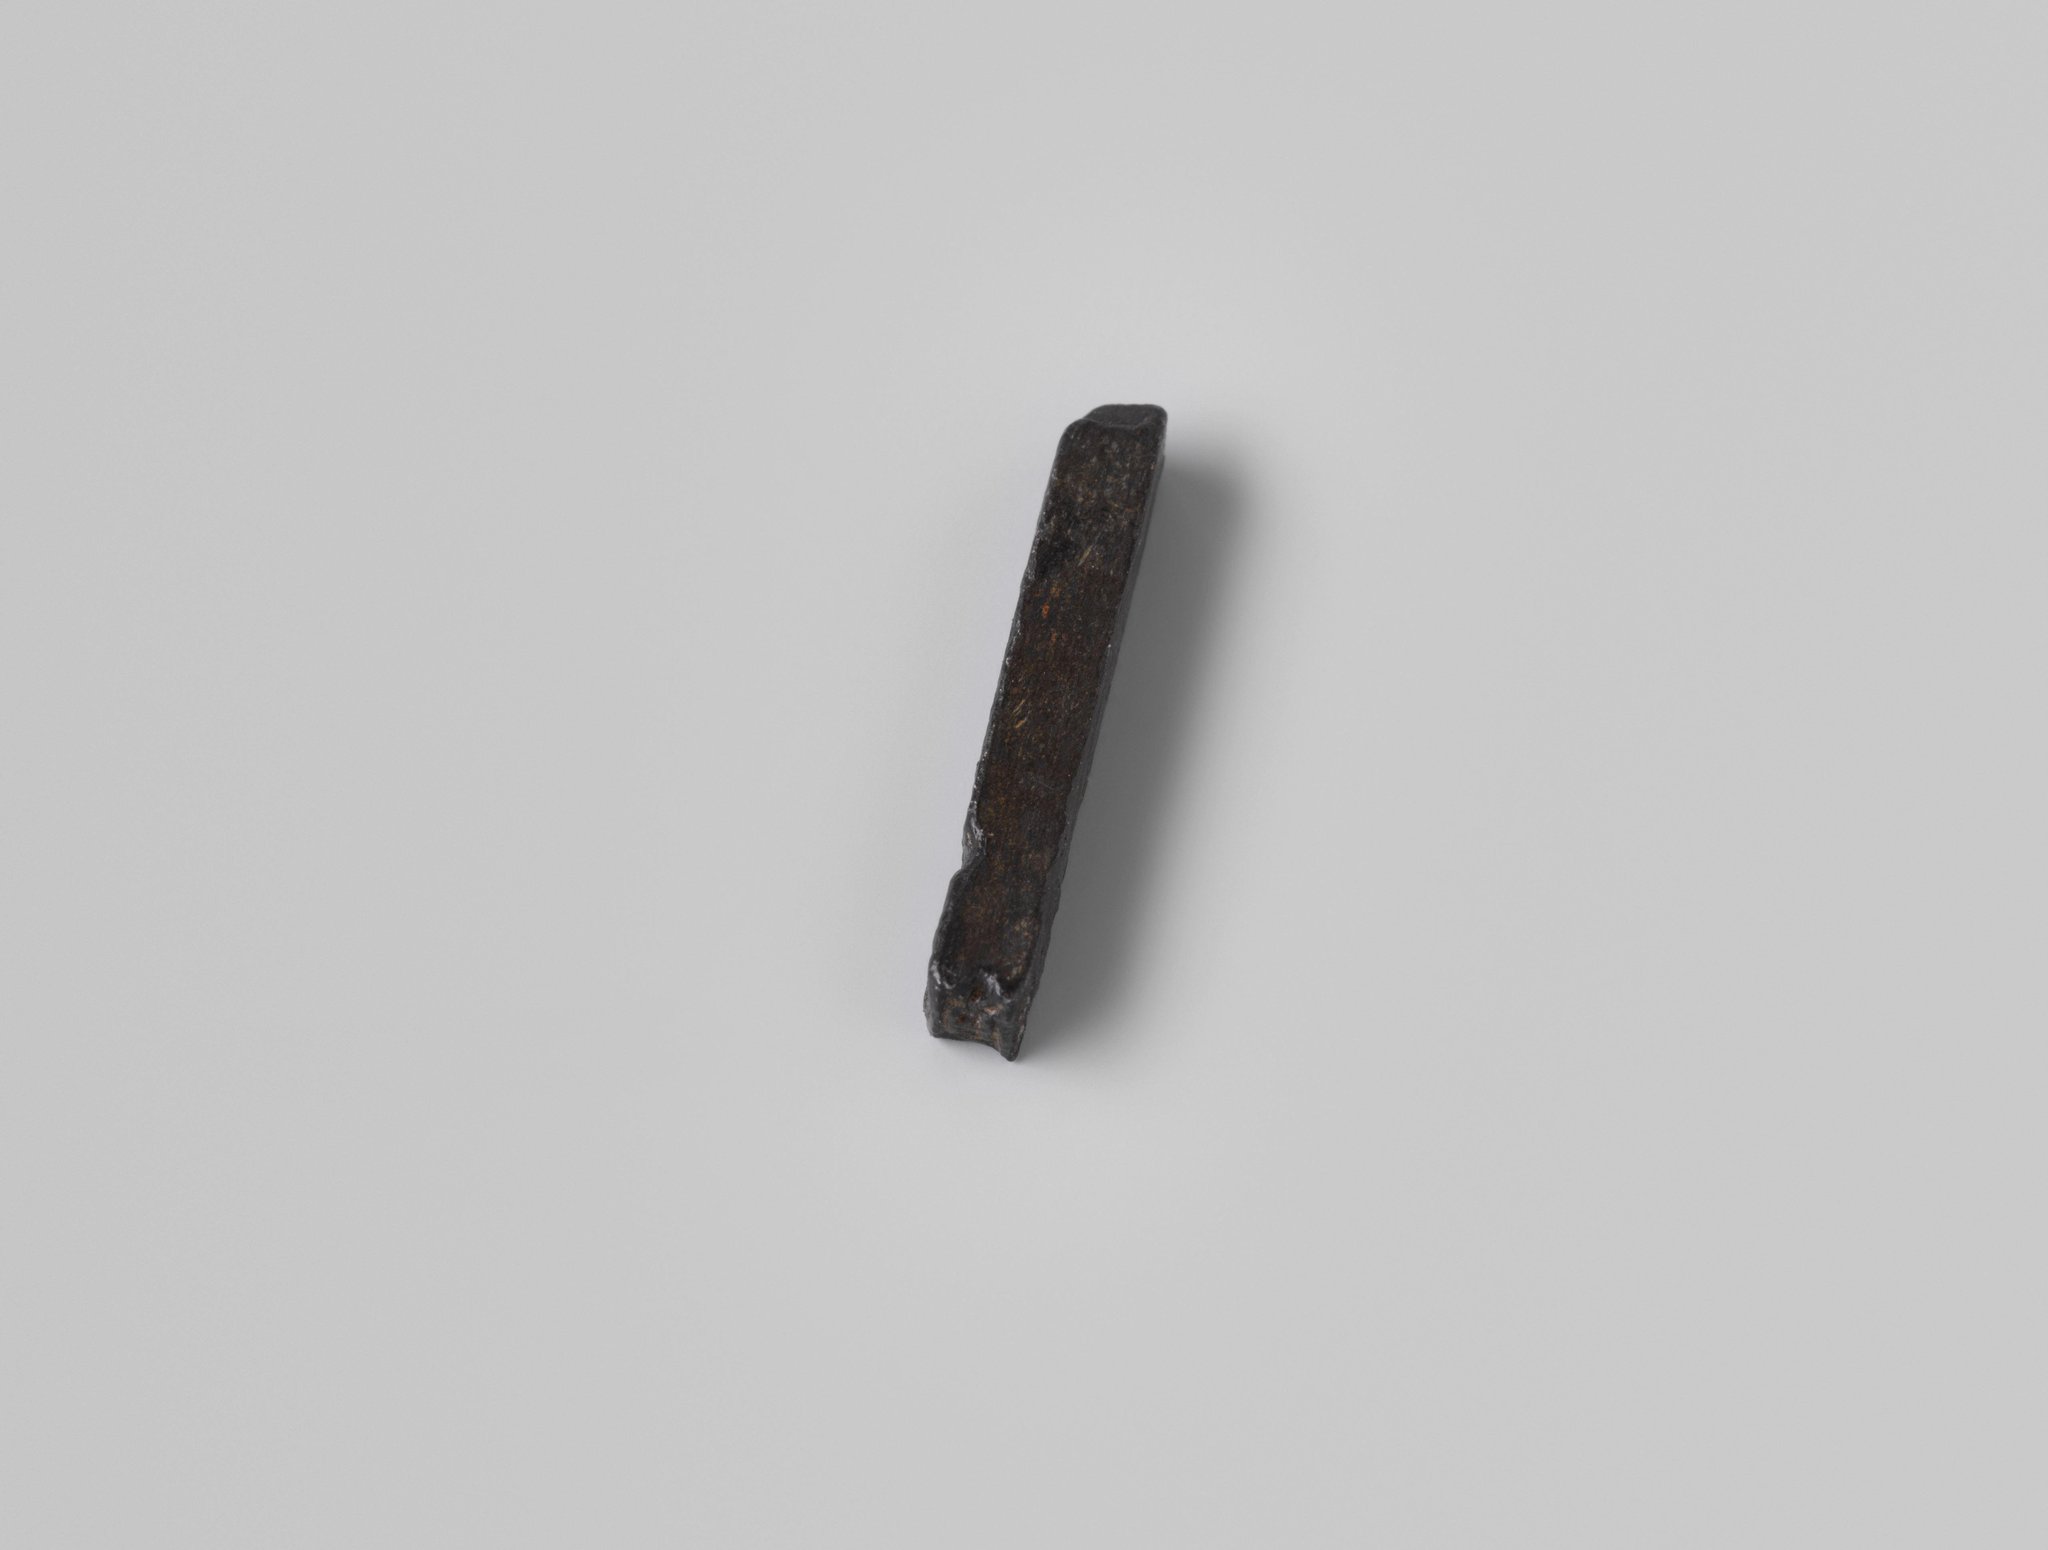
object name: type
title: Printing type with on one side the character W and on the other H, from the wreck of the Dutch East India ship Hollandia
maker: Anonymous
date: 1700-1743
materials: lead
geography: netherlands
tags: verenigde oostindische compagnie, hollandia (schip), annet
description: Printing type; square, groove in one side, 2 characters [W, H].